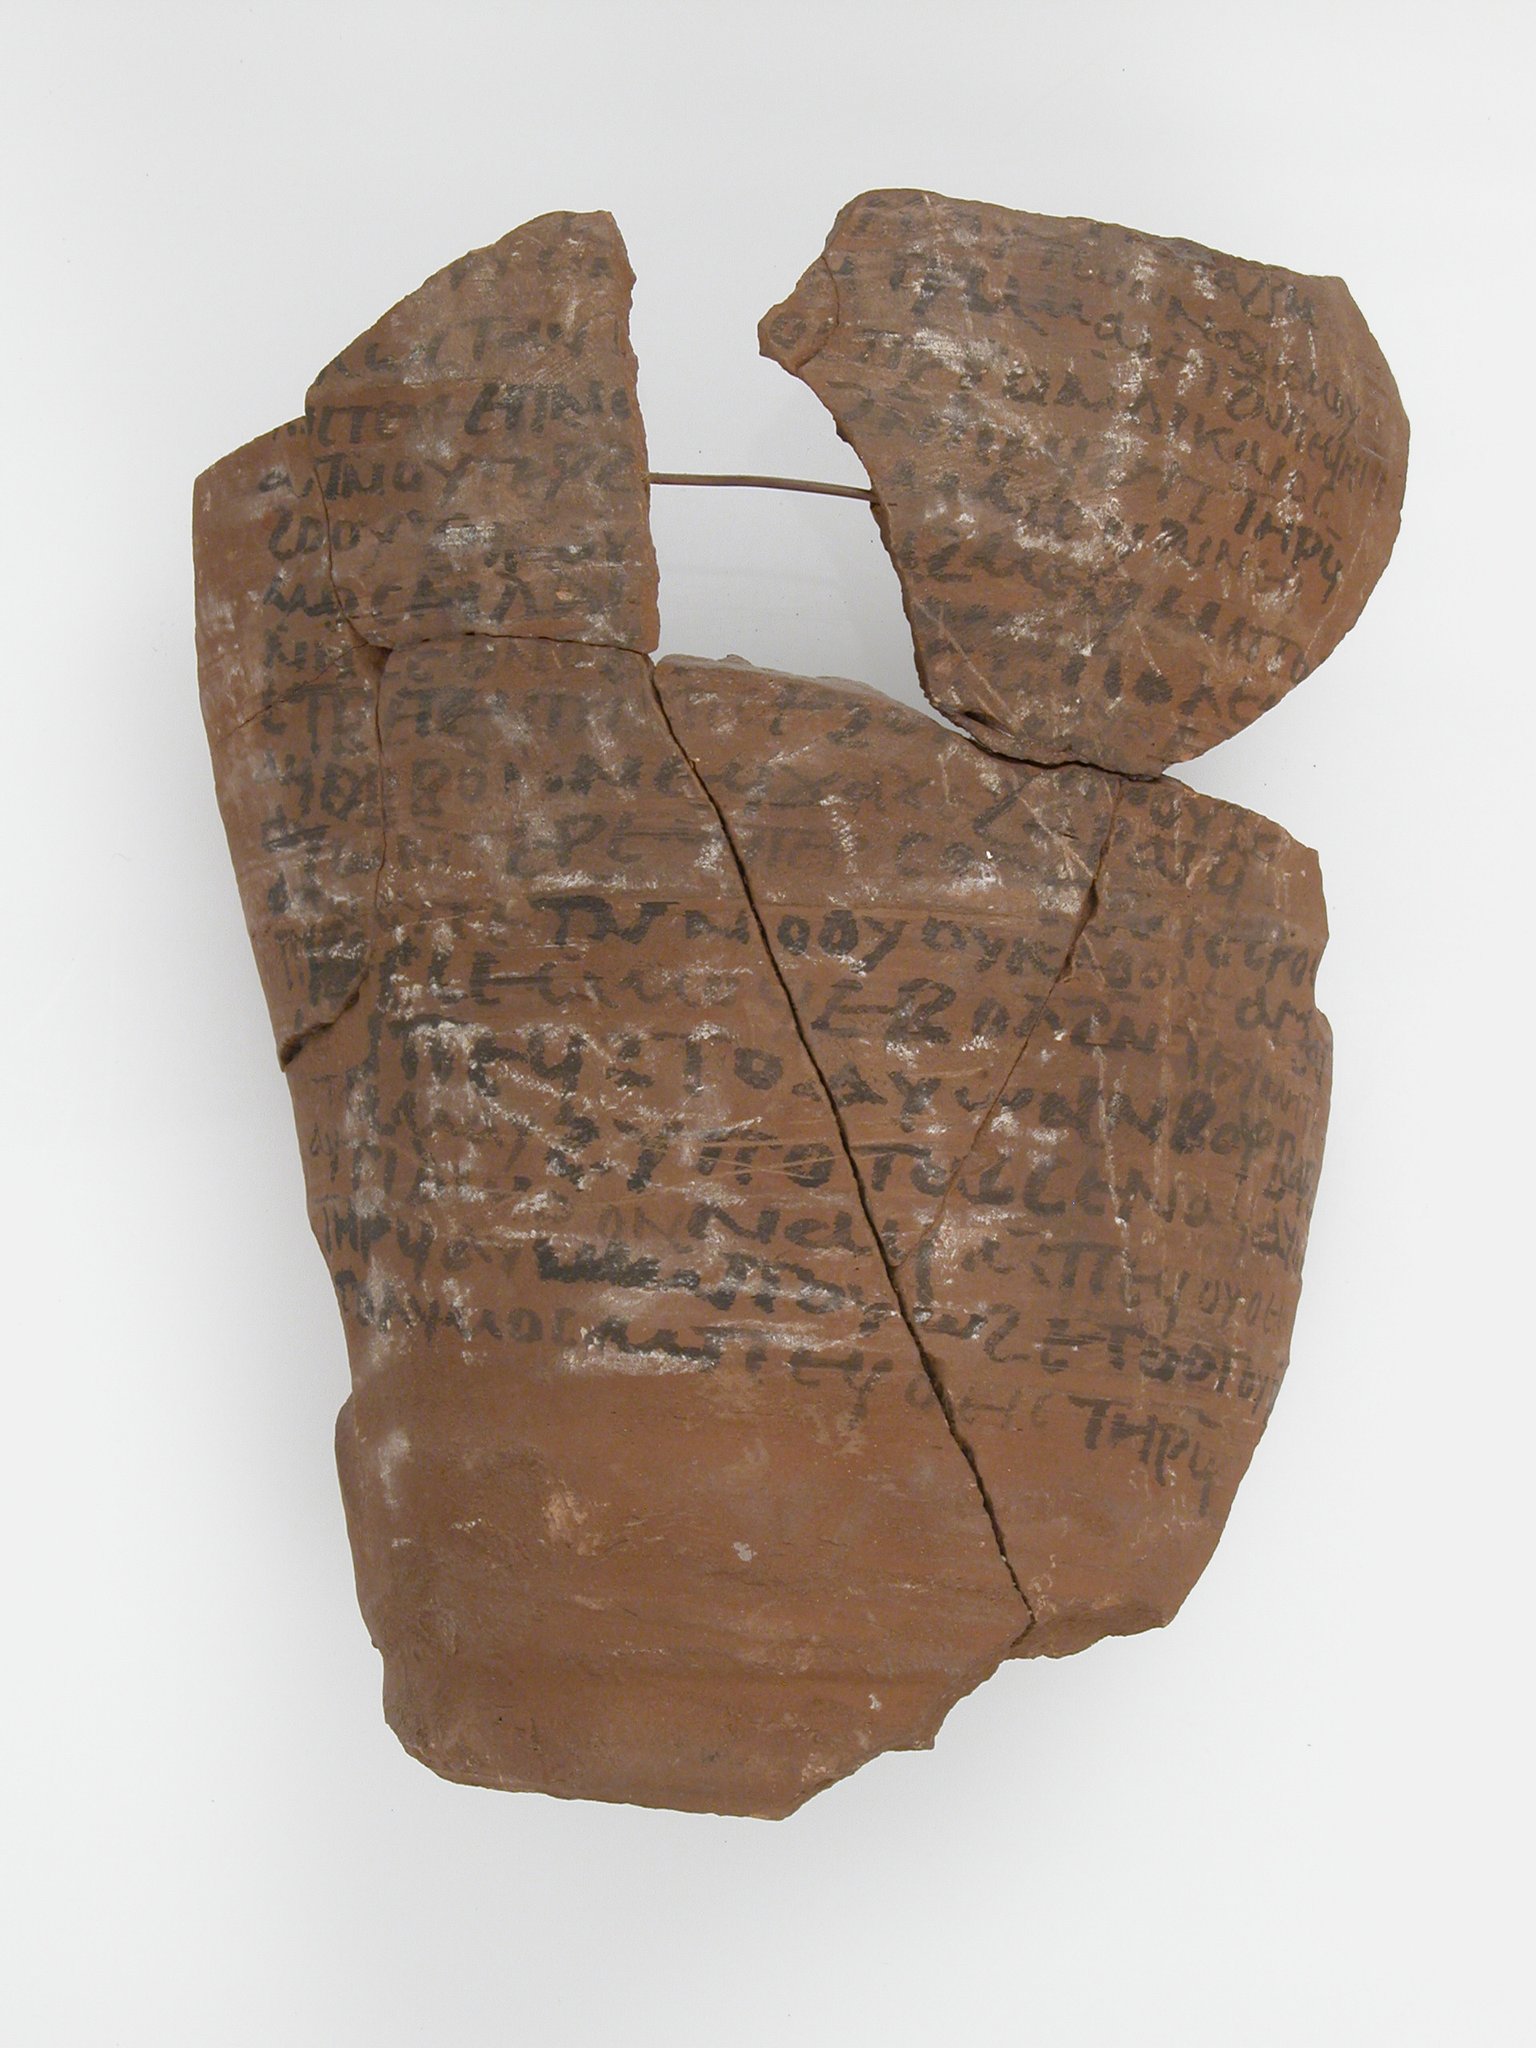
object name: ostrakon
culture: coptic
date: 601-700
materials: ink, pottery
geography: egypt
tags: documents